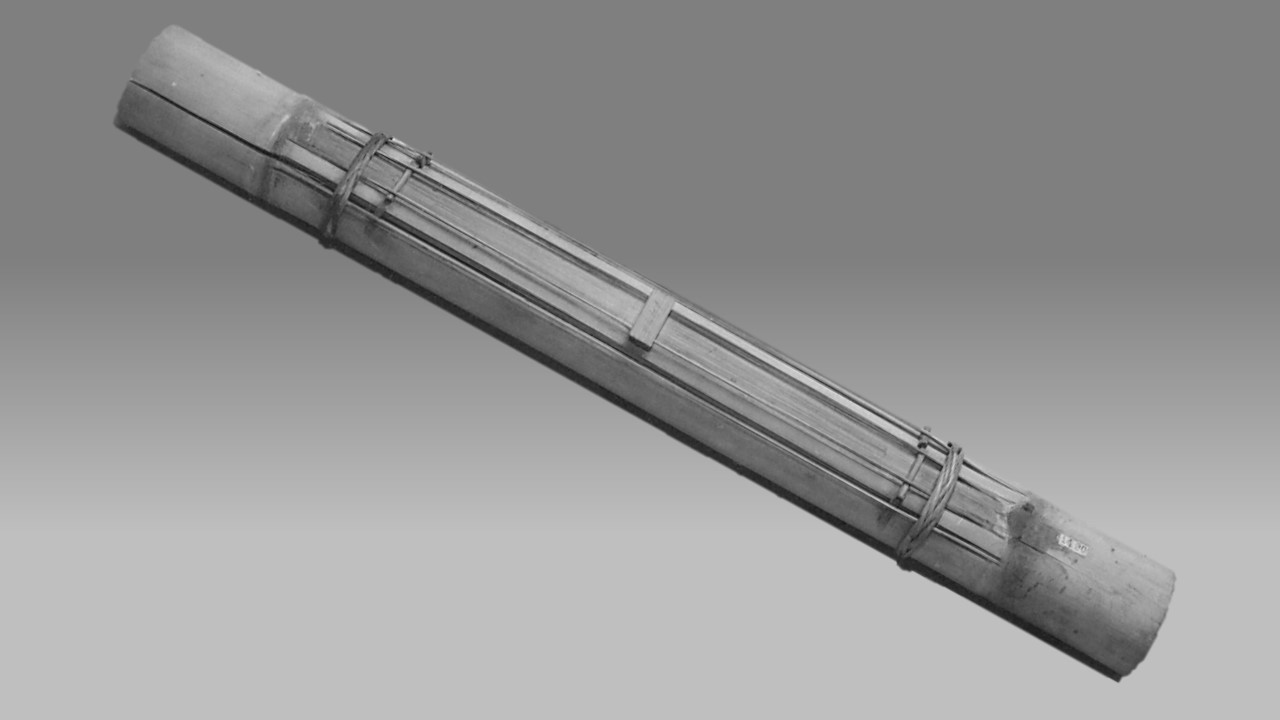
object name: takumbo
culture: philippine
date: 1867-1900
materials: bamboo, fiber